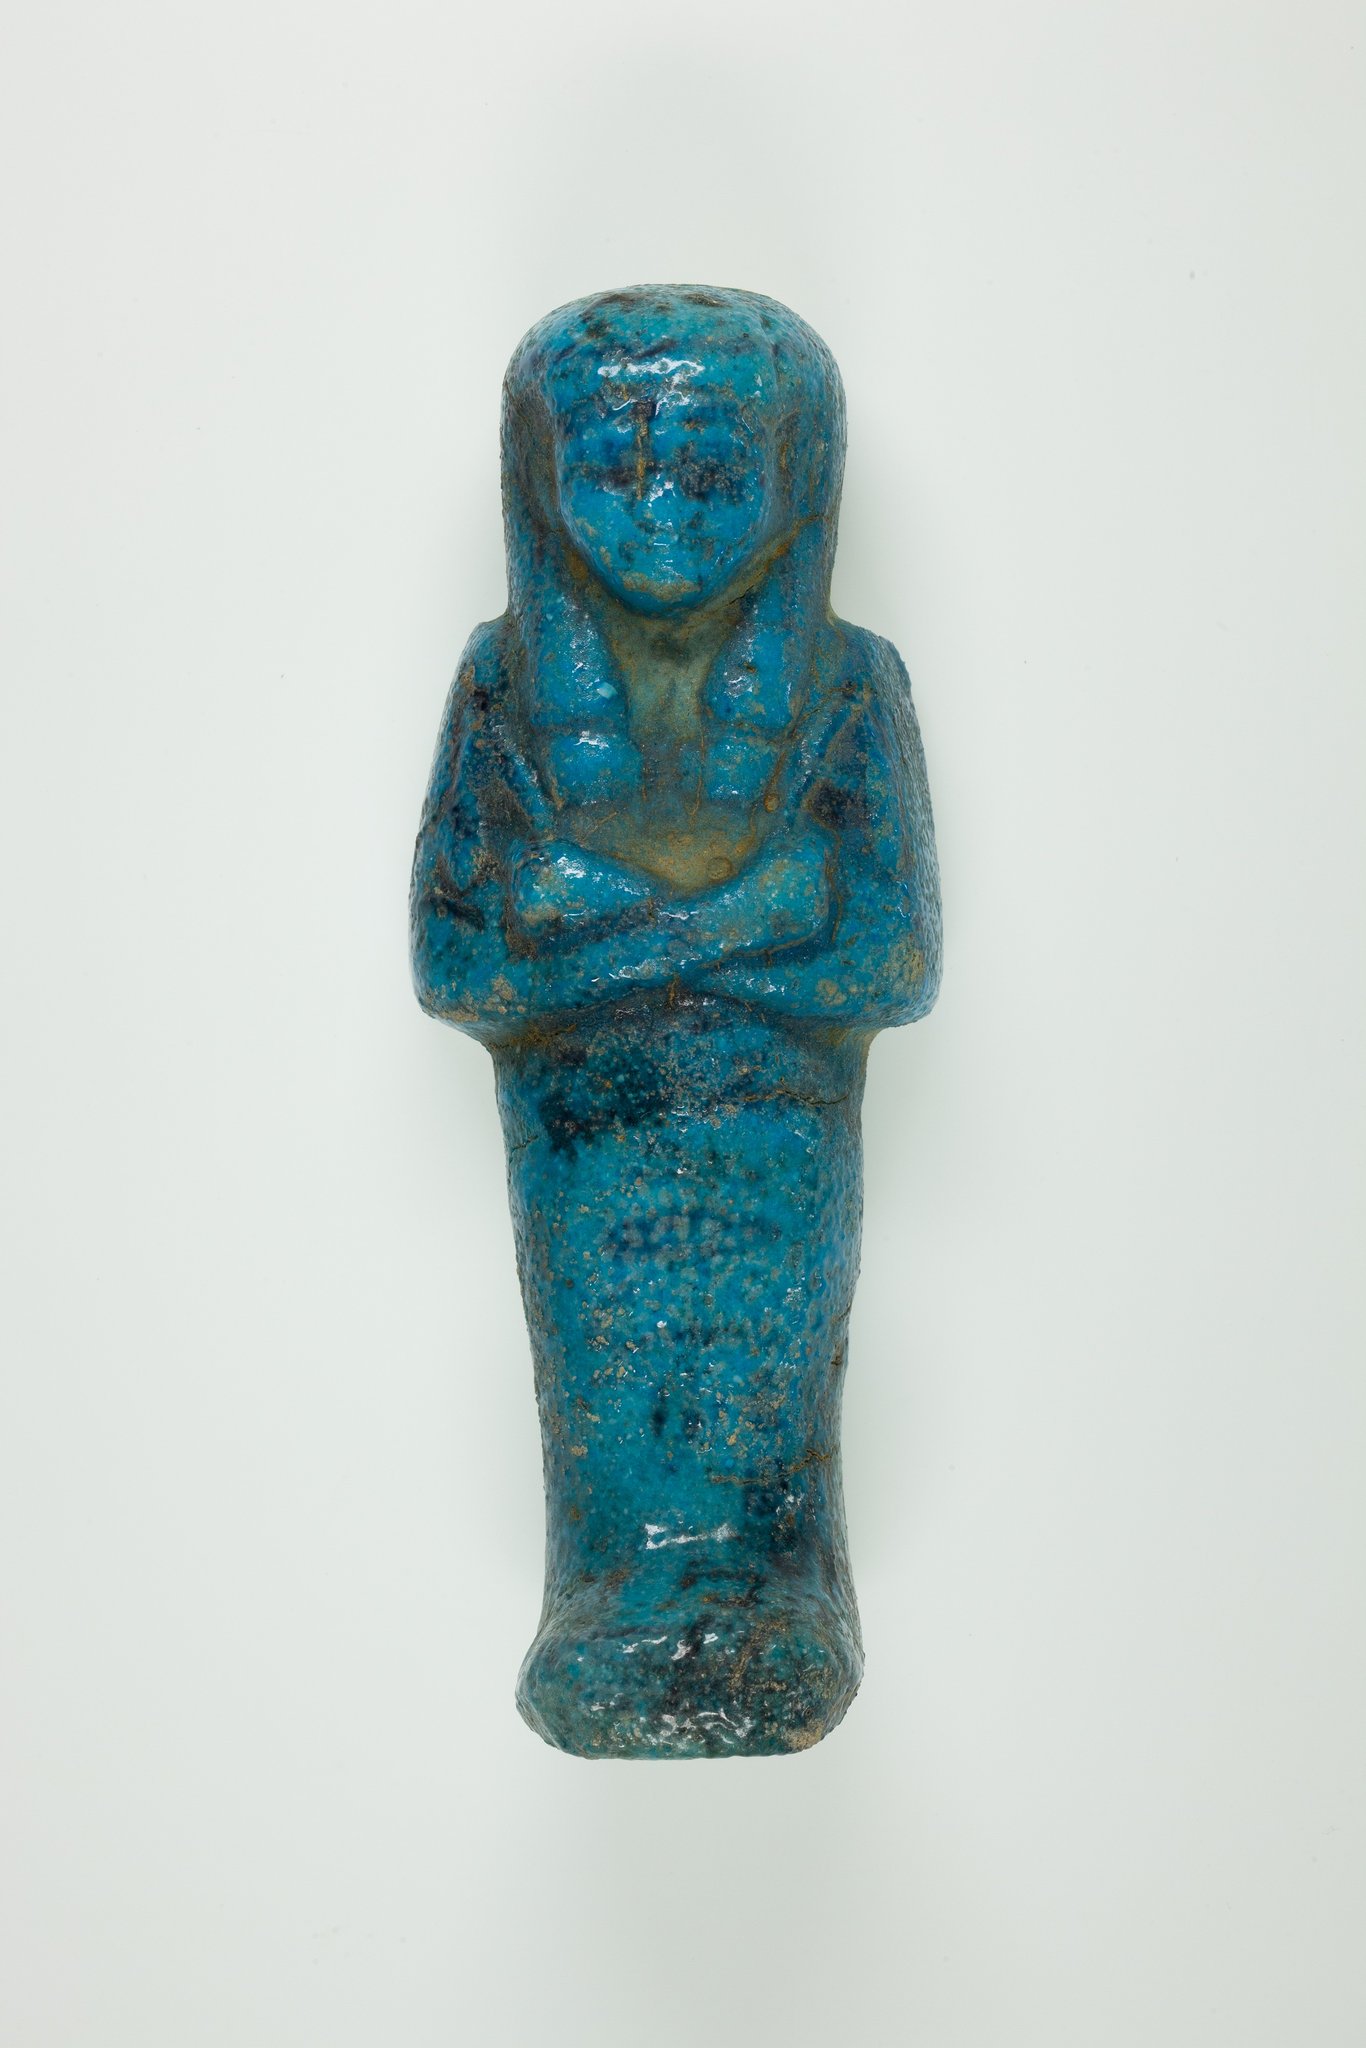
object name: worker shabti, henettawy c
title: Worker Shabti of Henettawy (C), Daughter of Isetemkheb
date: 990-970 BCE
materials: faience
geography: egypt